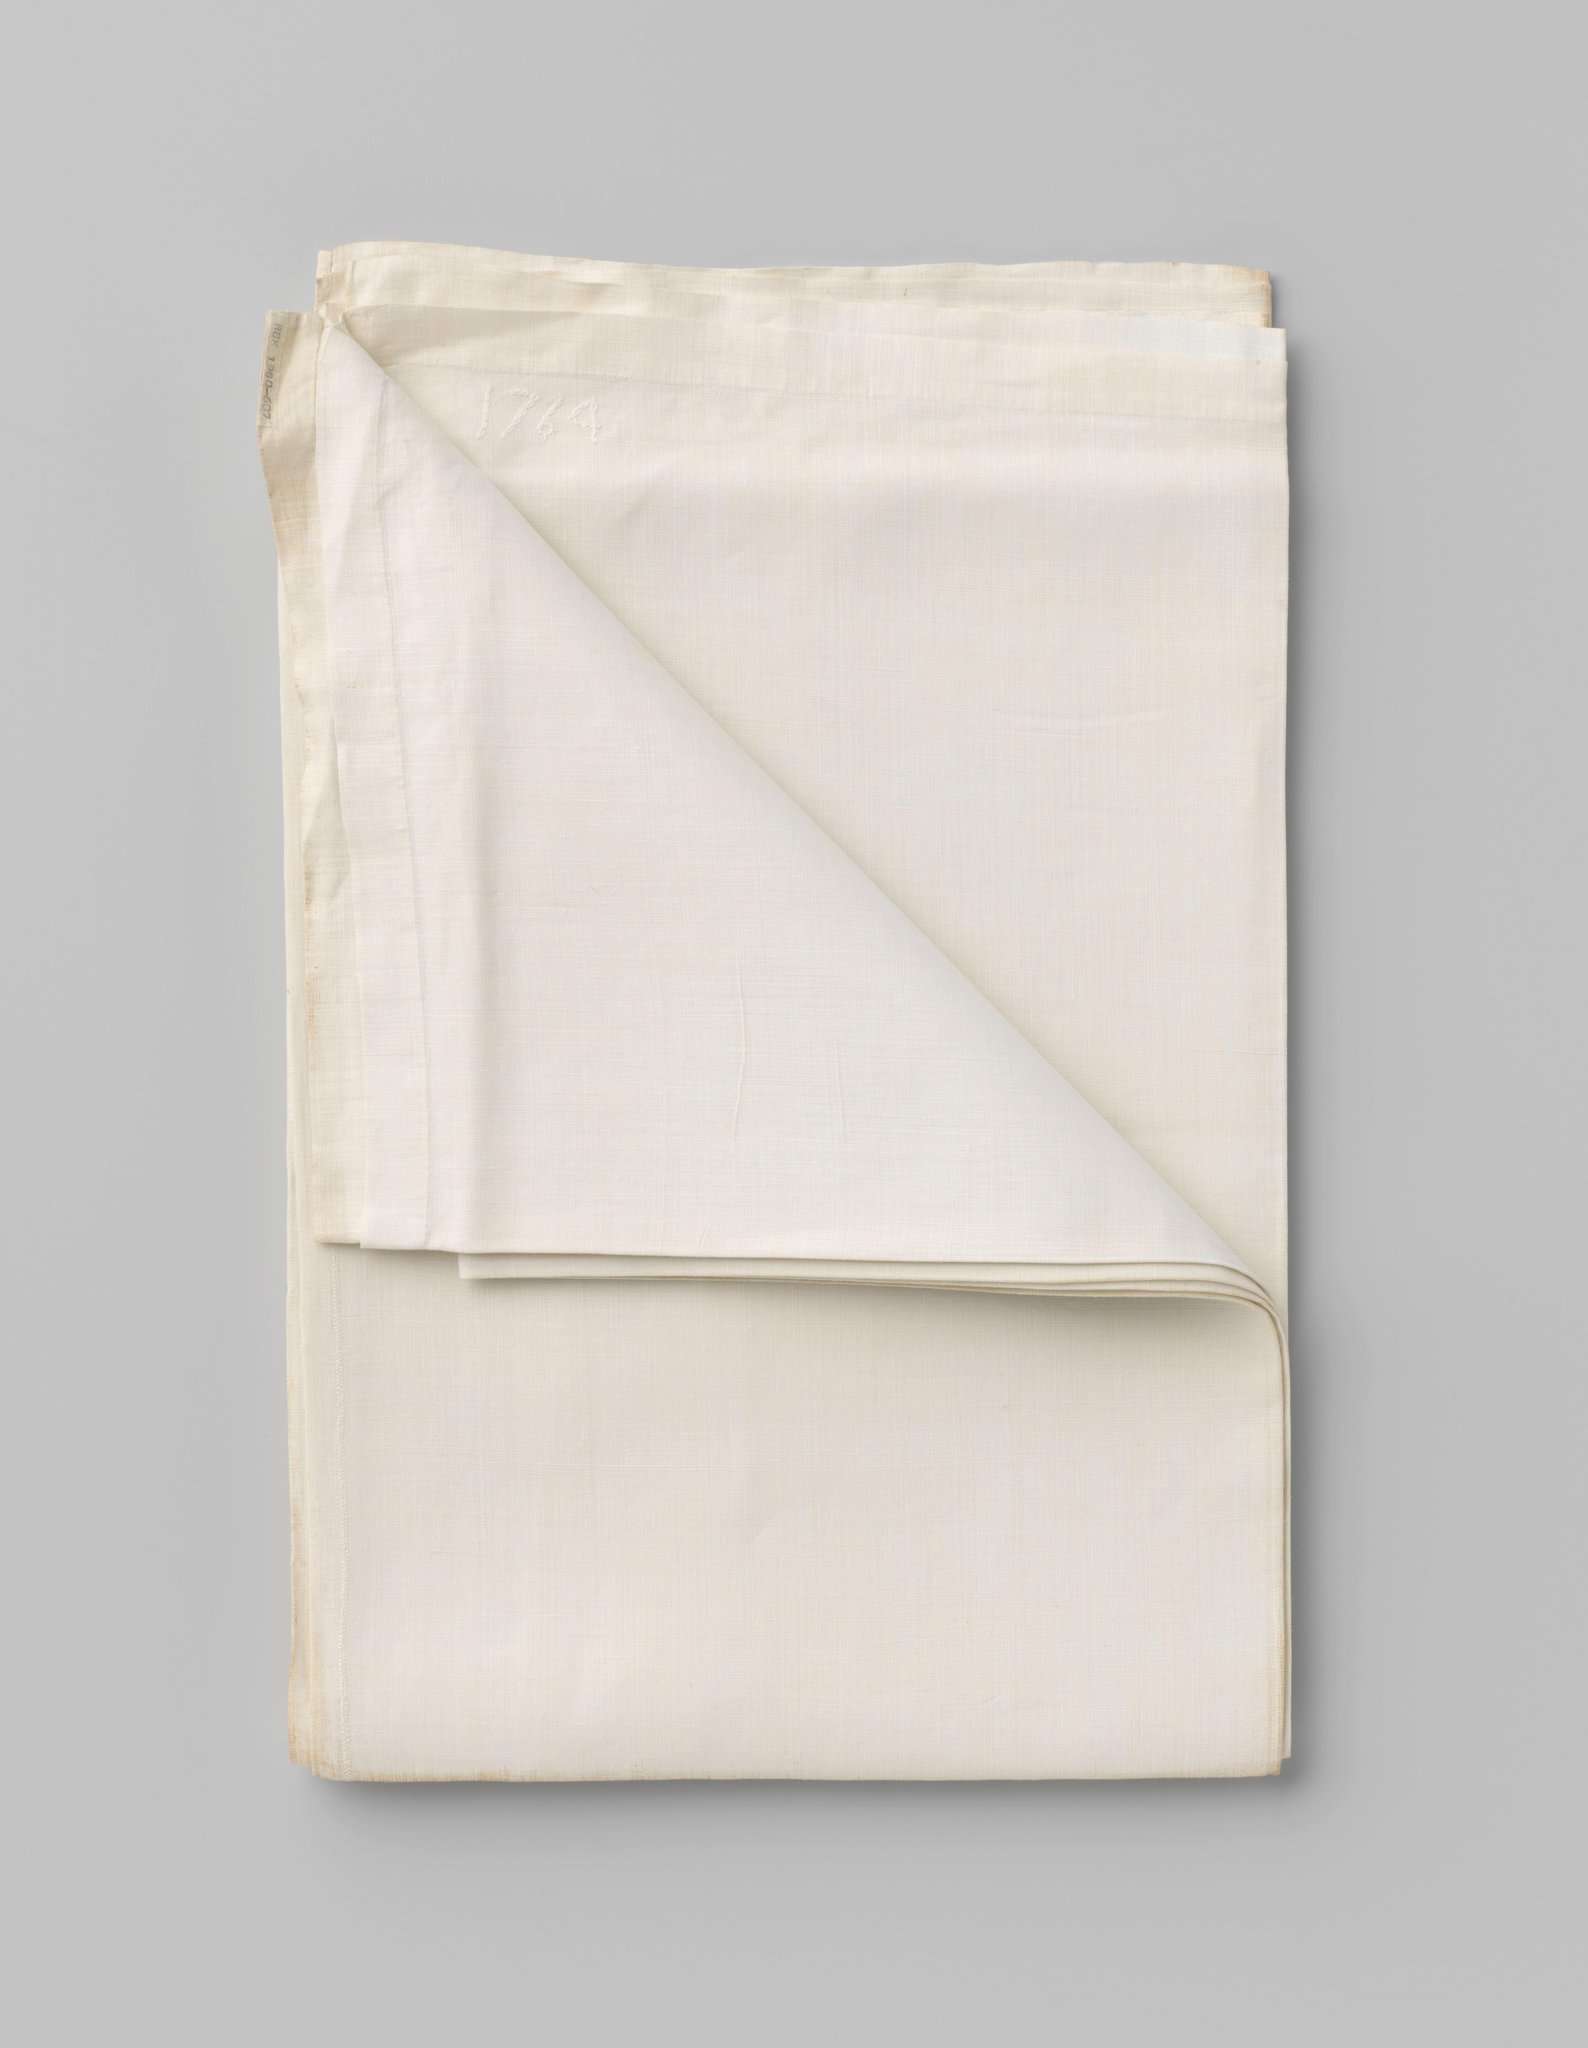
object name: beddenlaken, laken object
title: Laken. Merk: kroon G6 en jaartal 1764.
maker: Anonymous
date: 1764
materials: linen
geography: northern netherlands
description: Laken van wit linnen, merk kroon G 6 en jaartal 1764